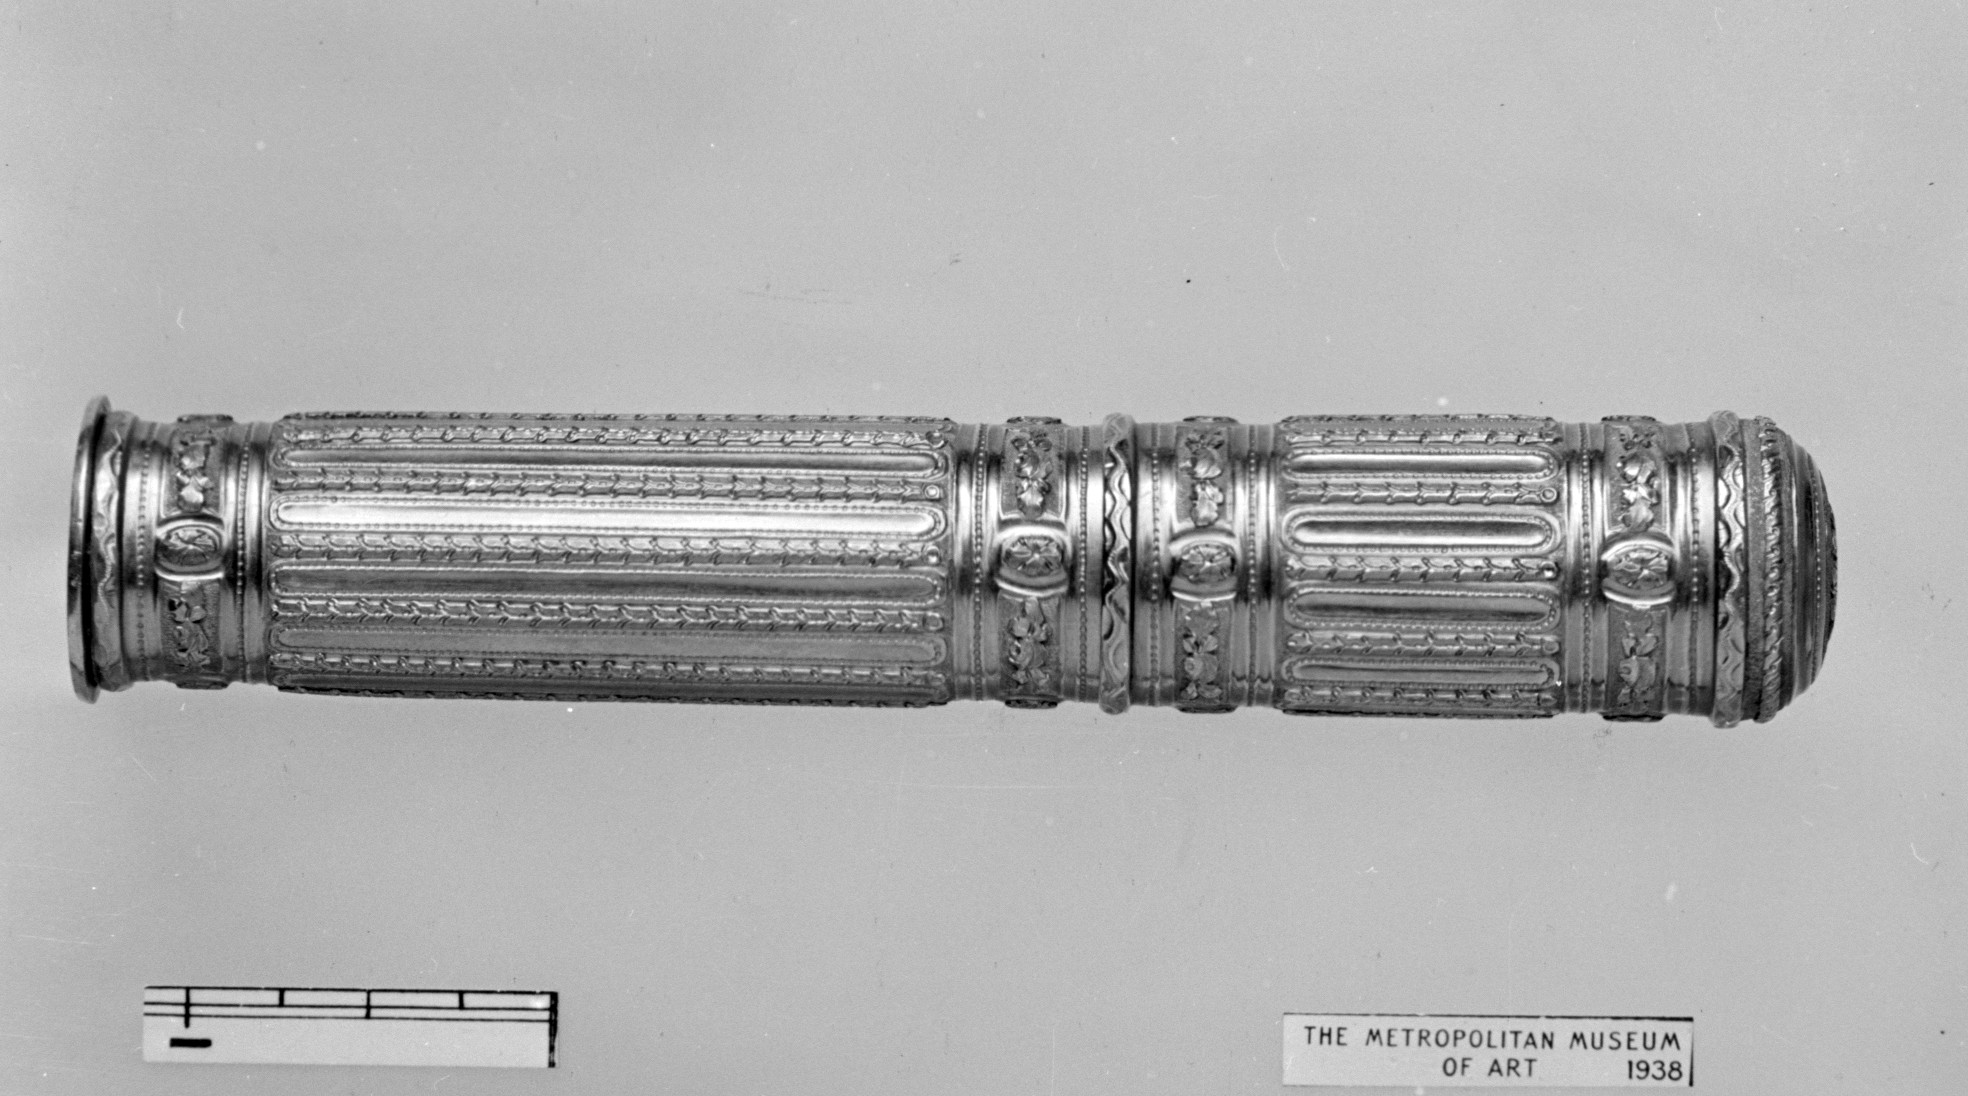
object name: étui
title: Sealing wax case (étui)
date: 1777-1778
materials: gold